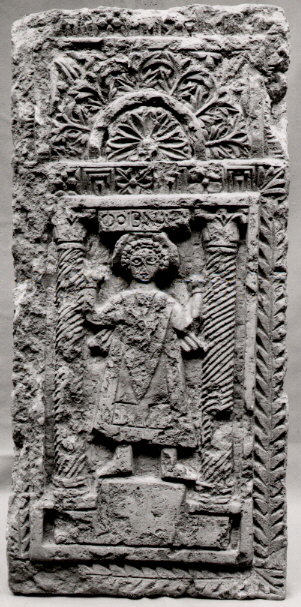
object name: stele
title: Funerary Stele with Orant Figure in Architectural Frame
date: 501-700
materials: limestone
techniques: carving, relief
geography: egypt